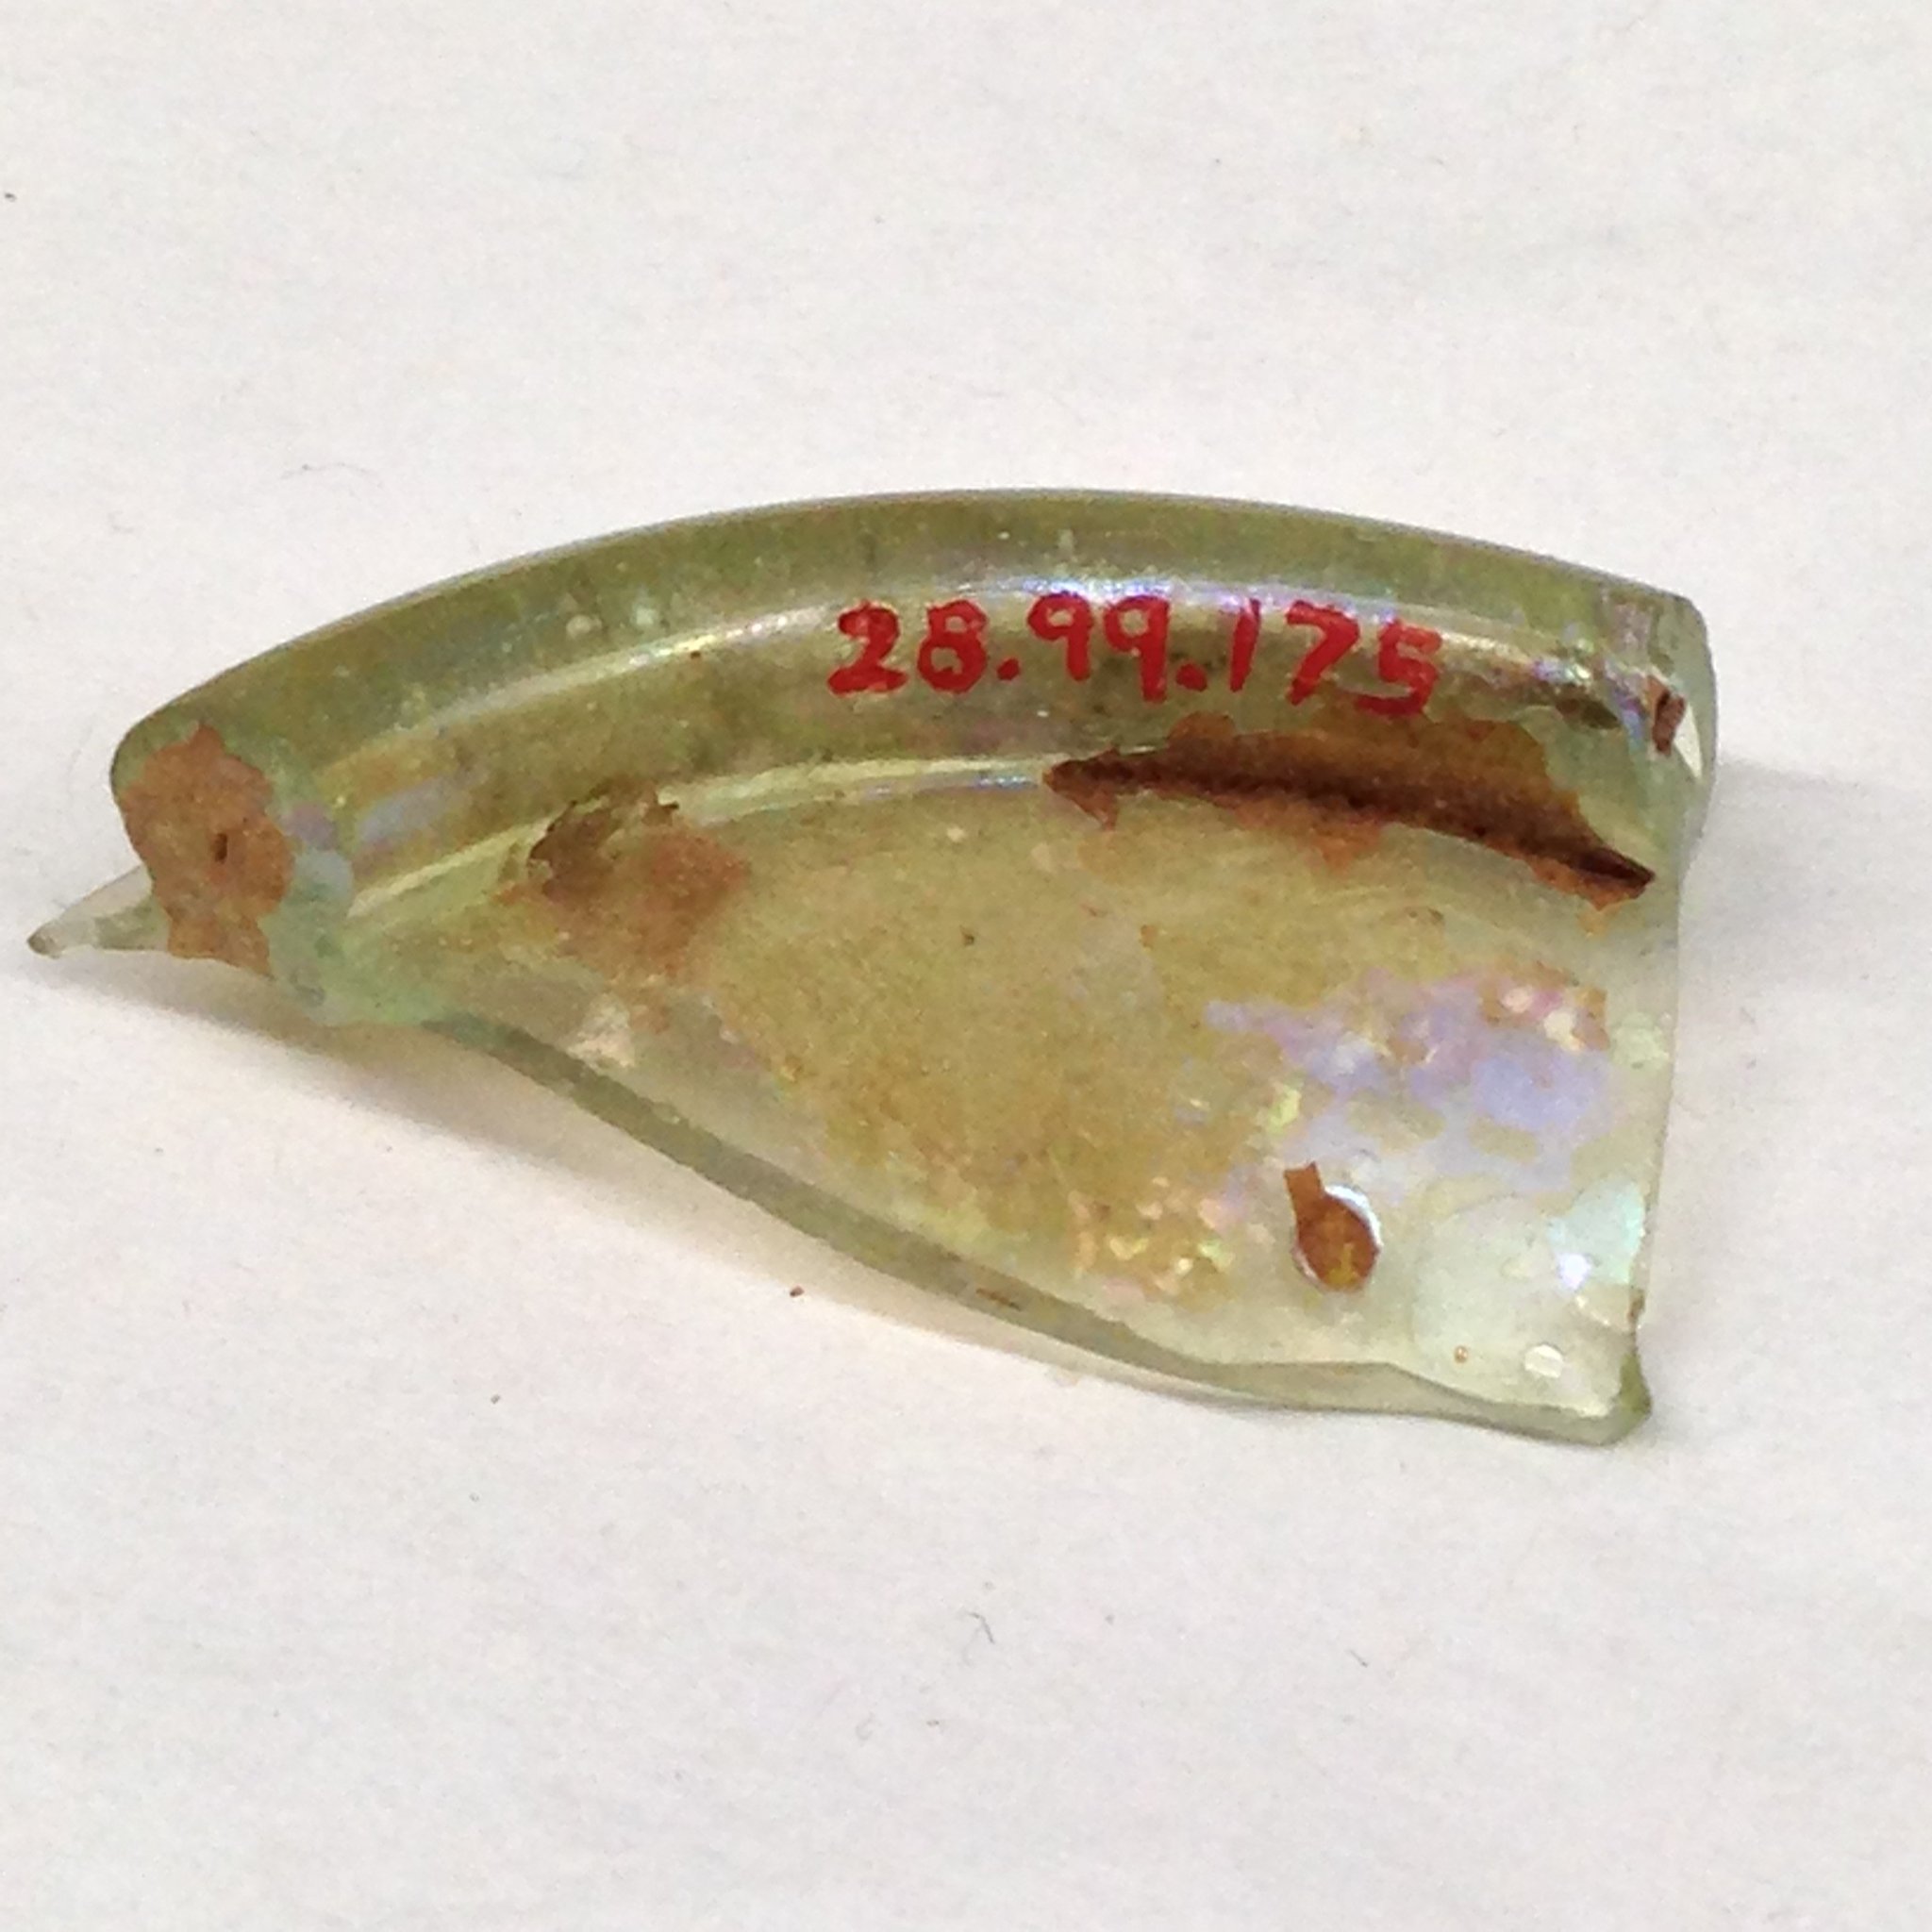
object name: fragment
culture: european or middle eastern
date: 1150-1250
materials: ceramic, glass